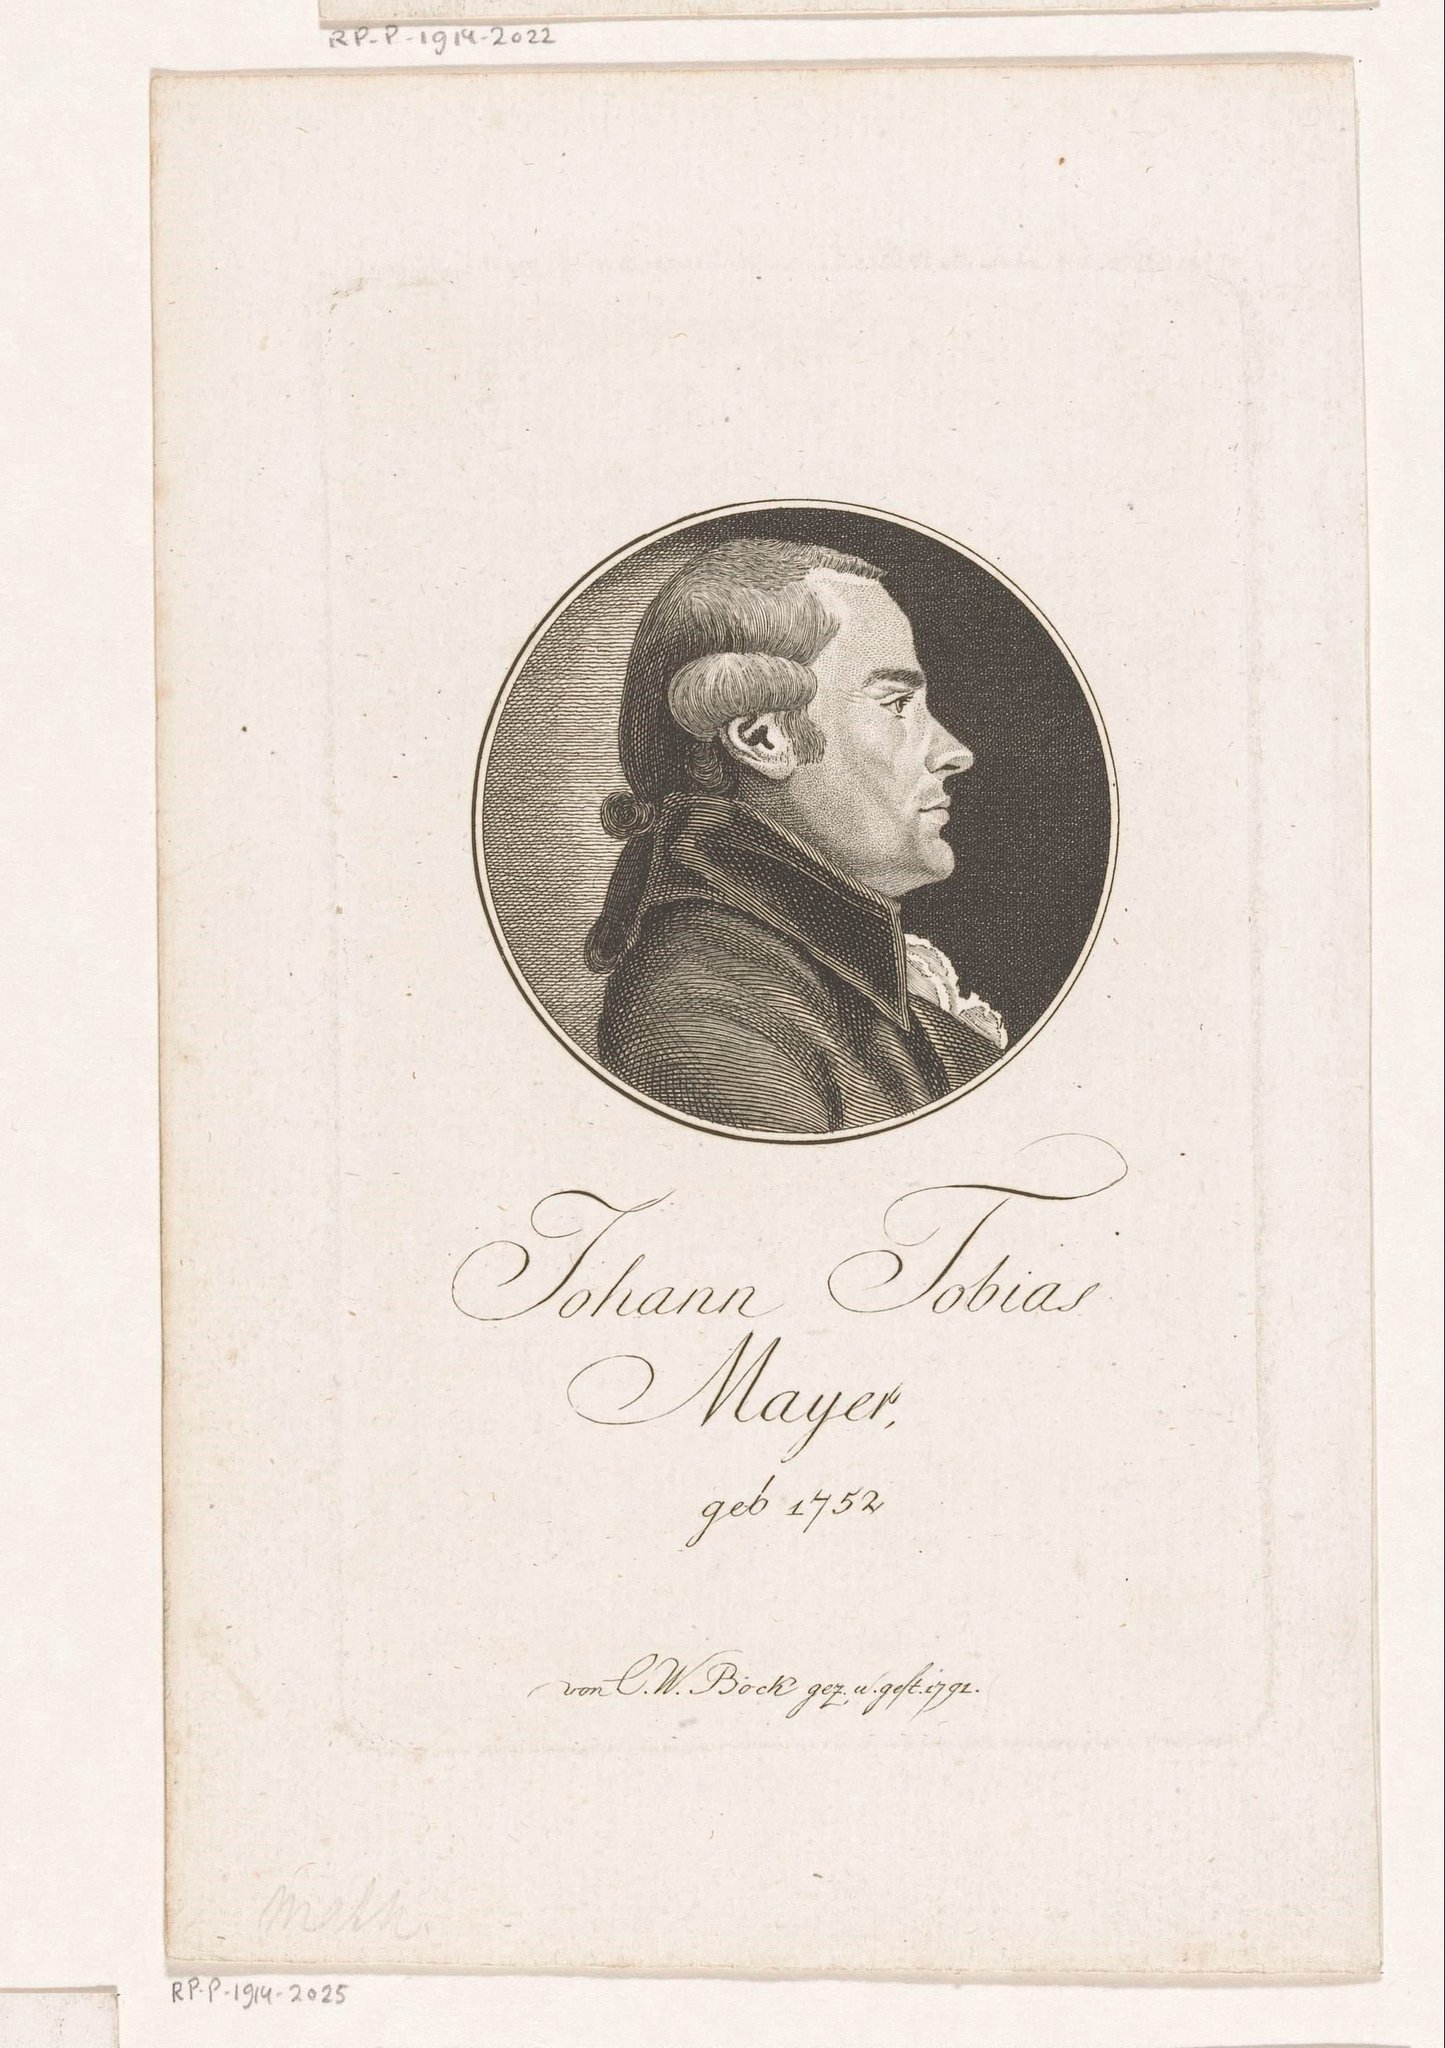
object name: print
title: Portret van Johann Tobias Mayer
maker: christoph wilhelm bock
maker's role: print maker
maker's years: 1755-1836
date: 1791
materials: paper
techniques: engraving, etching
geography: nuremberg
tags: physicist, historical persons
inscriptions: collector's mark: Lugt 2228